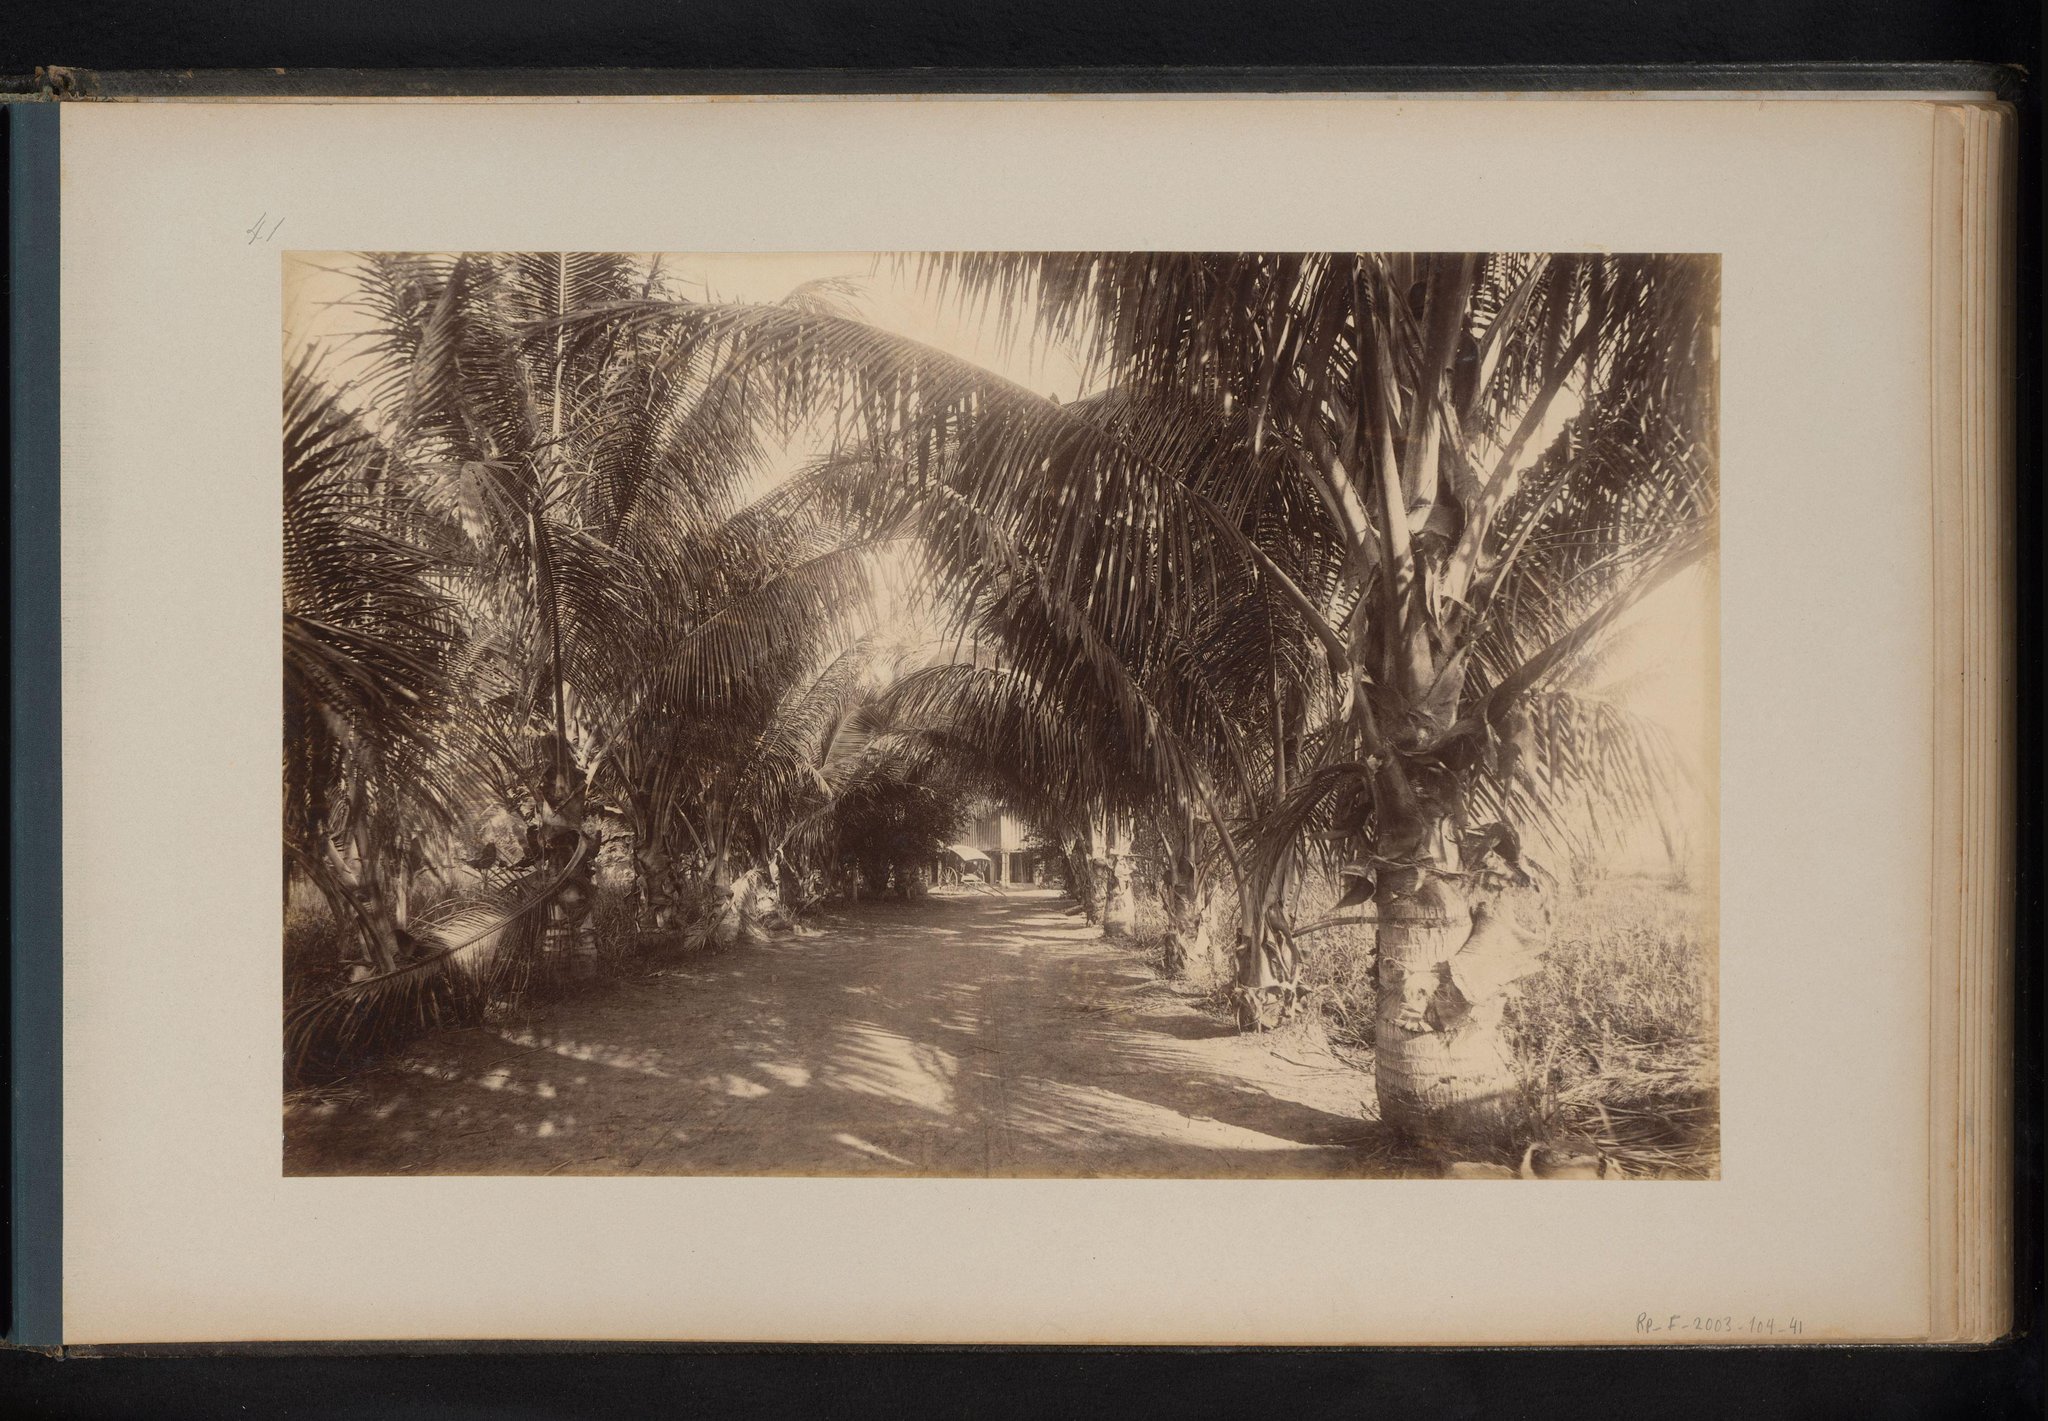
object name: photograph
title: Laan met palmbomen in Soengei Diski, Sumatra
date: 1890-1900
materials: cardboard, photographic support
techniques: albumen print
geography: sumatra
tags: road, path, trees: palm-tree, sumatra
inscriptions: number: ‘41’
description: In de lijst van afbeeldingen wordt deze foto beschreven met de woorden "Kokospalmen-Allee in Soengei Diski".